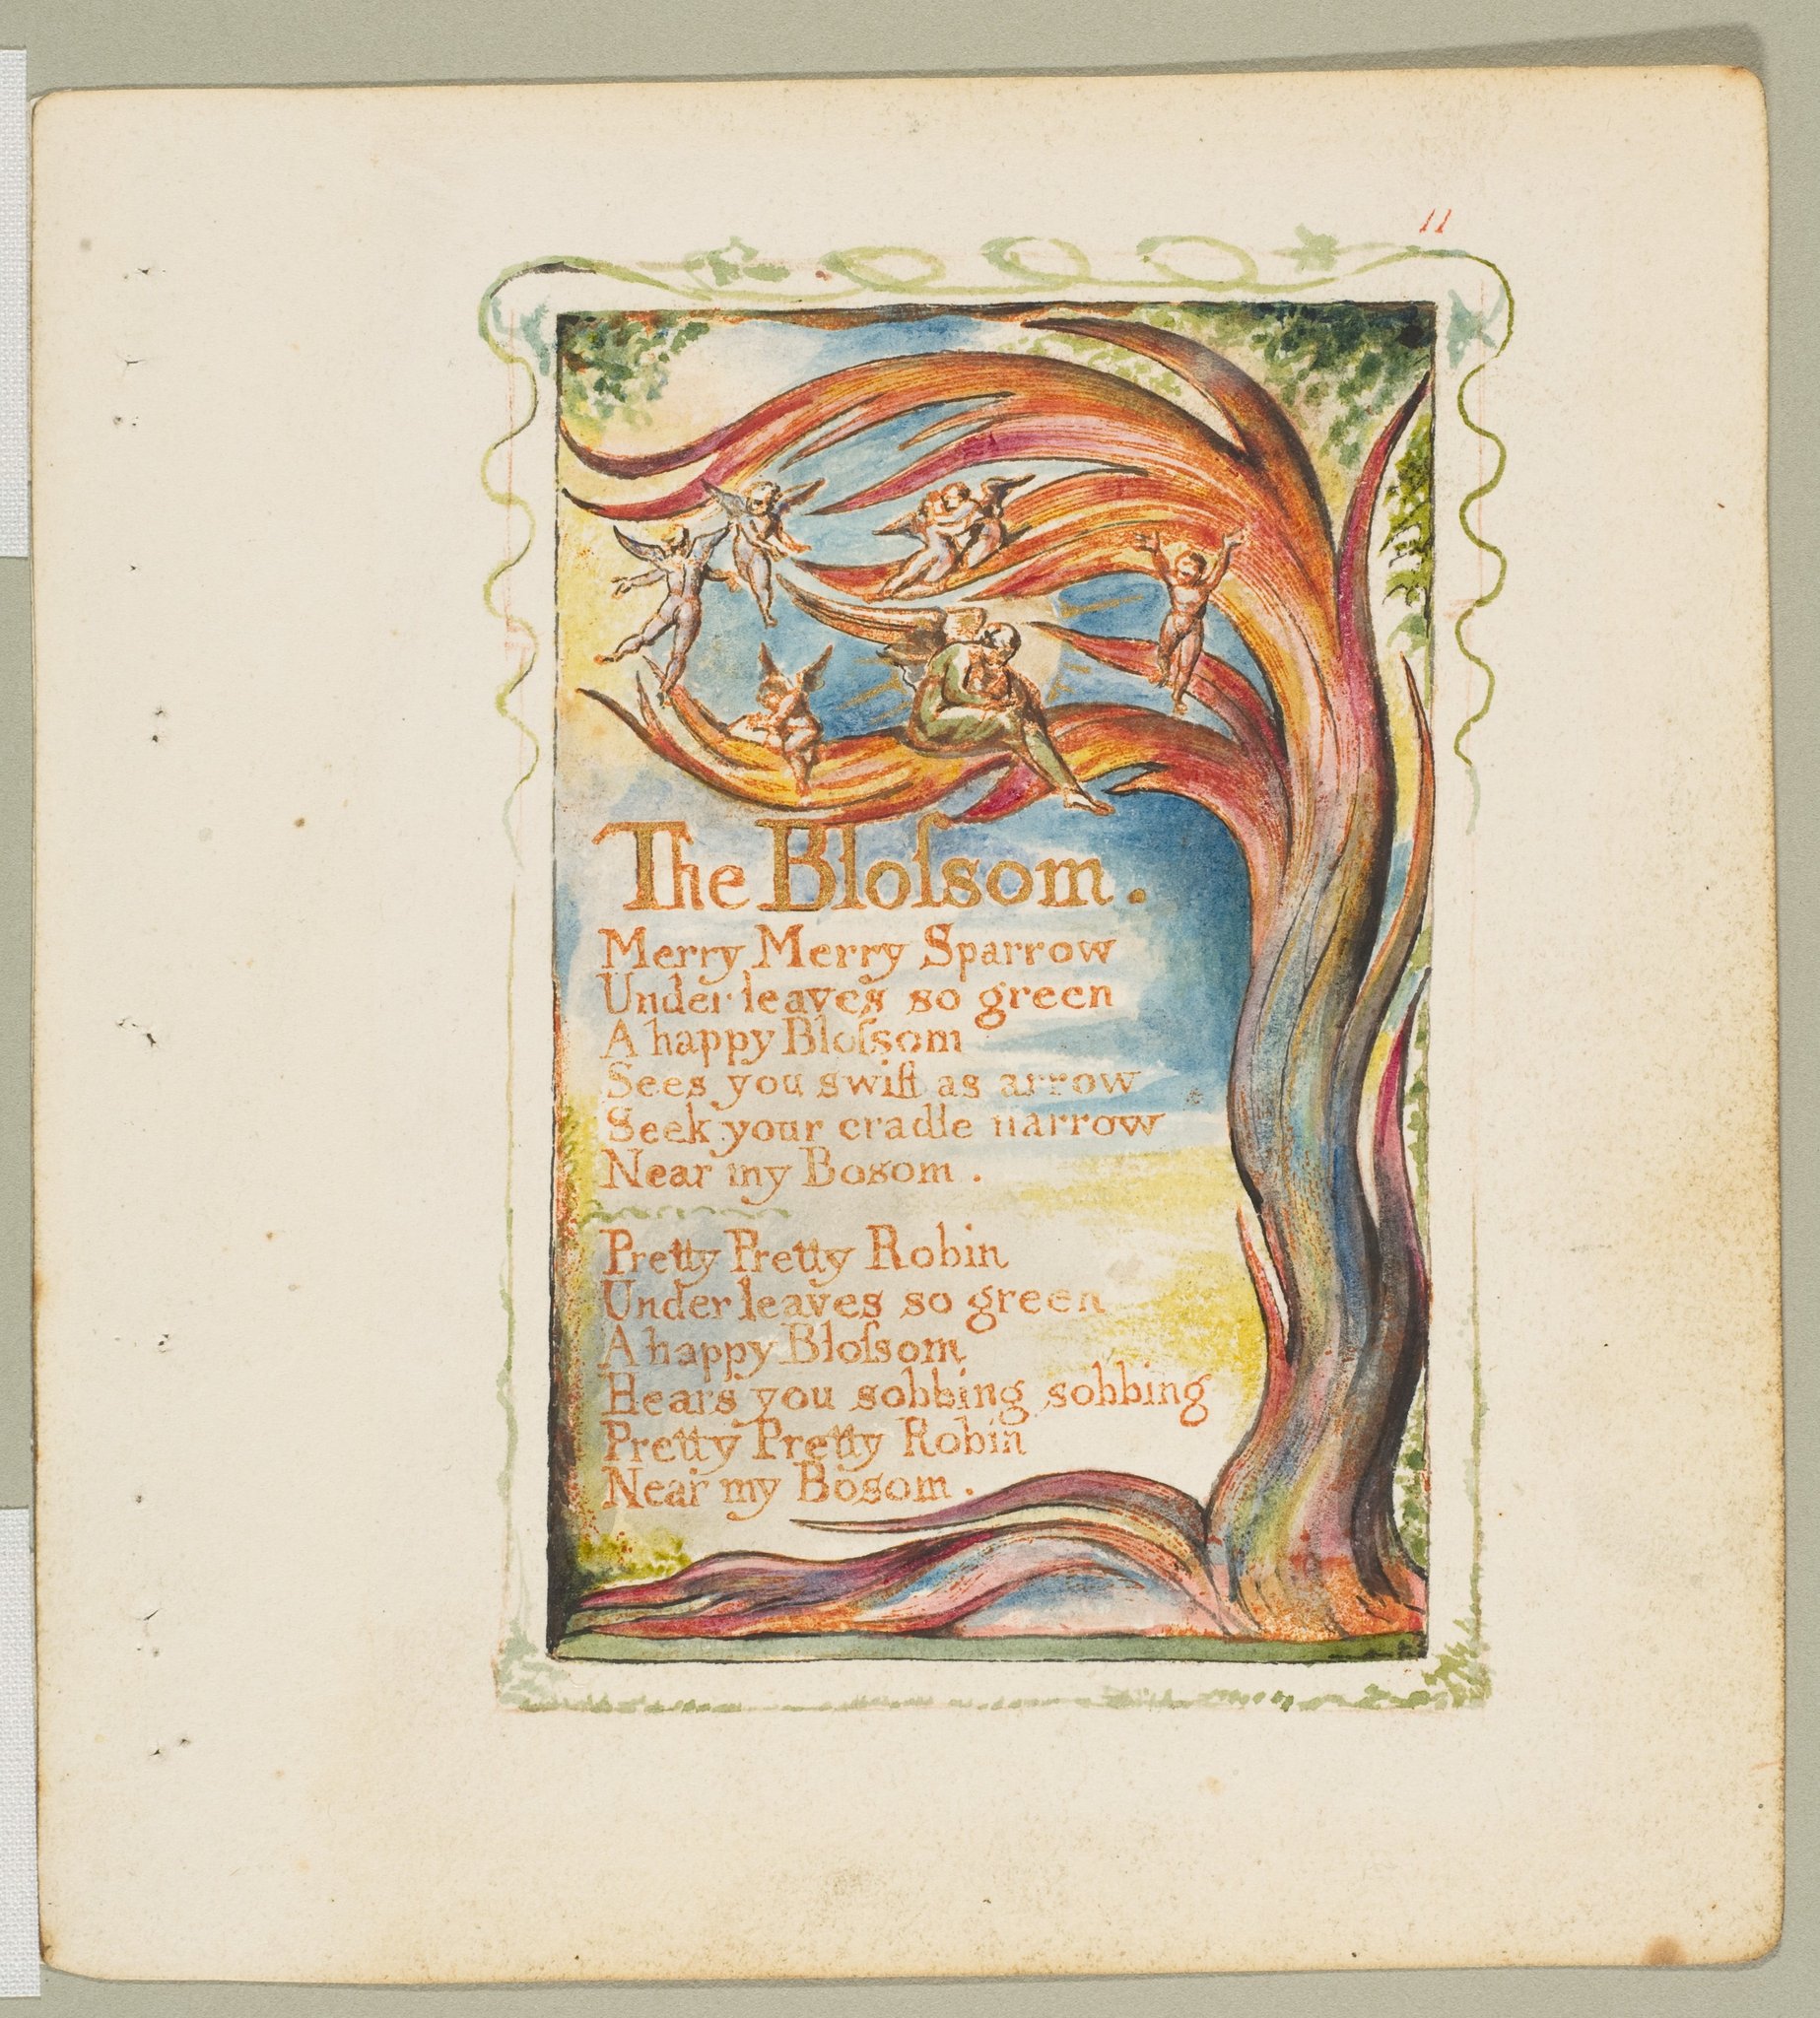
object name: print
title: Songs of Innocence: The Blossom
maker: william blake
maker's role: artist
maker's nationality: british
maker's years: 1757-1827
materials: gold, ink, shell, watercolor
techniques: etching, hand coloring, printing, relief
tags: poetry